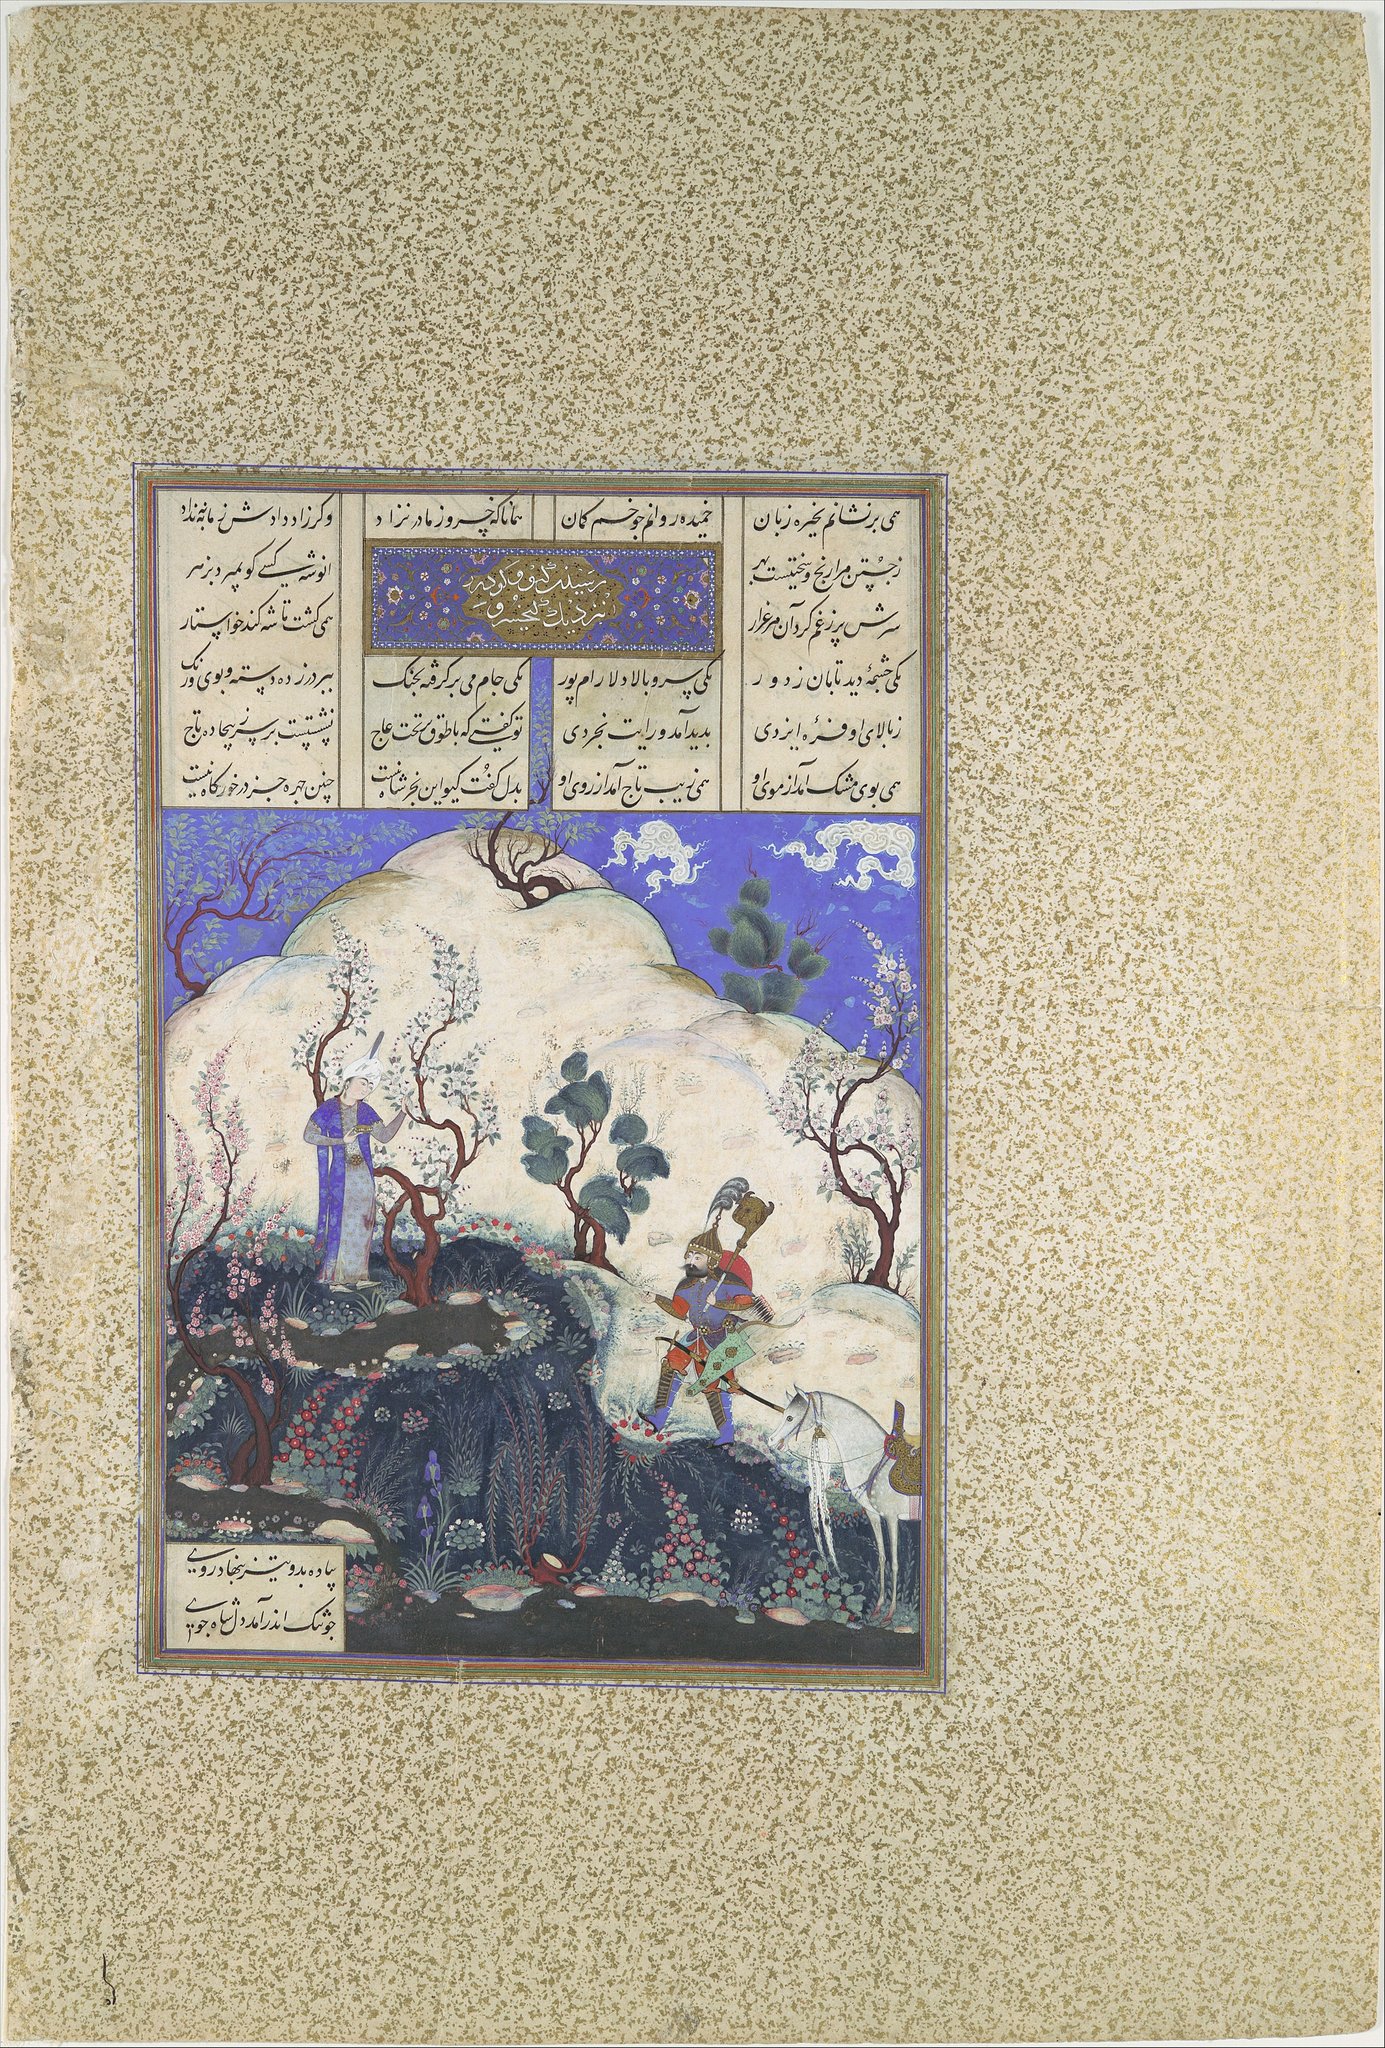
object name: folio from an illustrated manuscript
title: "Kai Khusrau is Discovered by Giv", Folio 210v from the Shahnama (Book of Kings) of Shah Tahmasp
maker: abu'l qasim firdausi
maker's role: author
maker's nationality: iranian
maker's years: 935-1020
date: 1525-1530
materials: gold, ink, paper, silver, watercolor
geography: iran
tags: men,horses